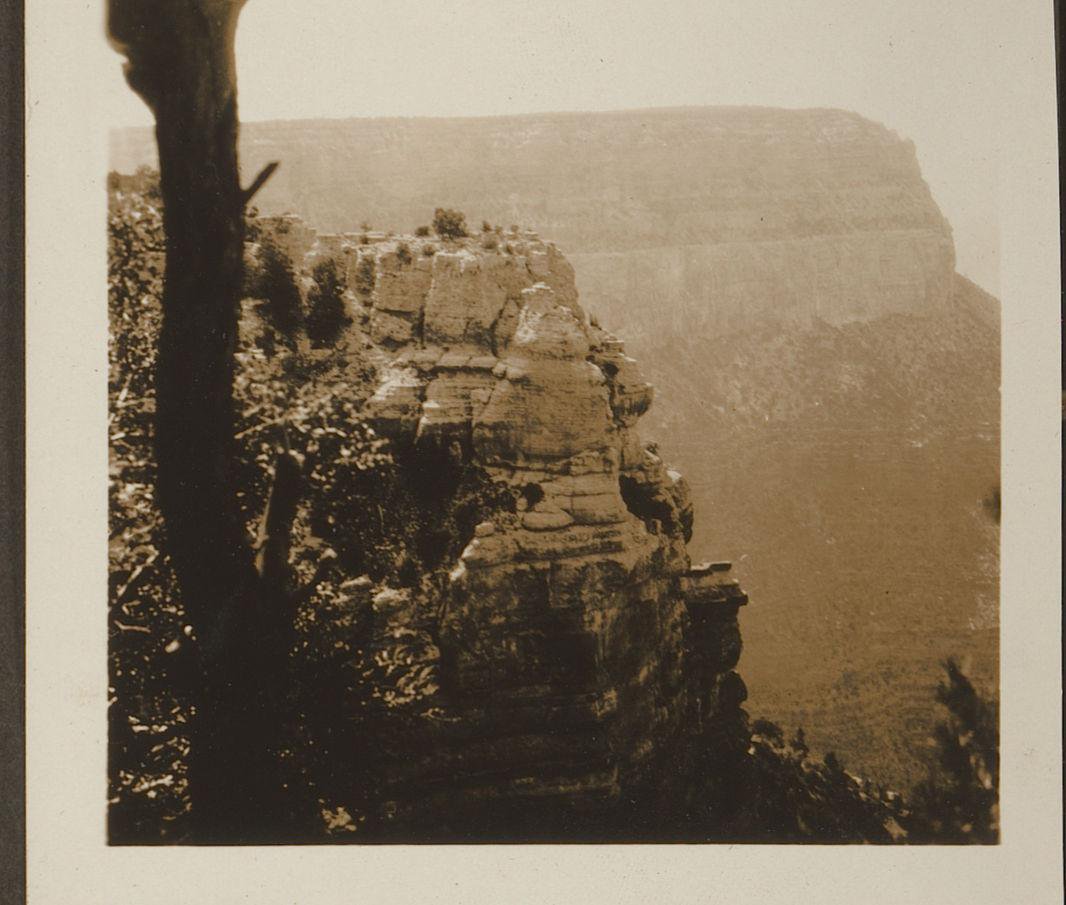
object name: album leaf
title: Uitzicht over de Grand Canyon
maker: Anonymous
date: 1928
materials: photographic support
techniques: gelatin silver print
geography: grand canyon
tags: ravine, chasm, abyss, canyon, mountains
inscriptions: annotation: ‘Grand Canyon’